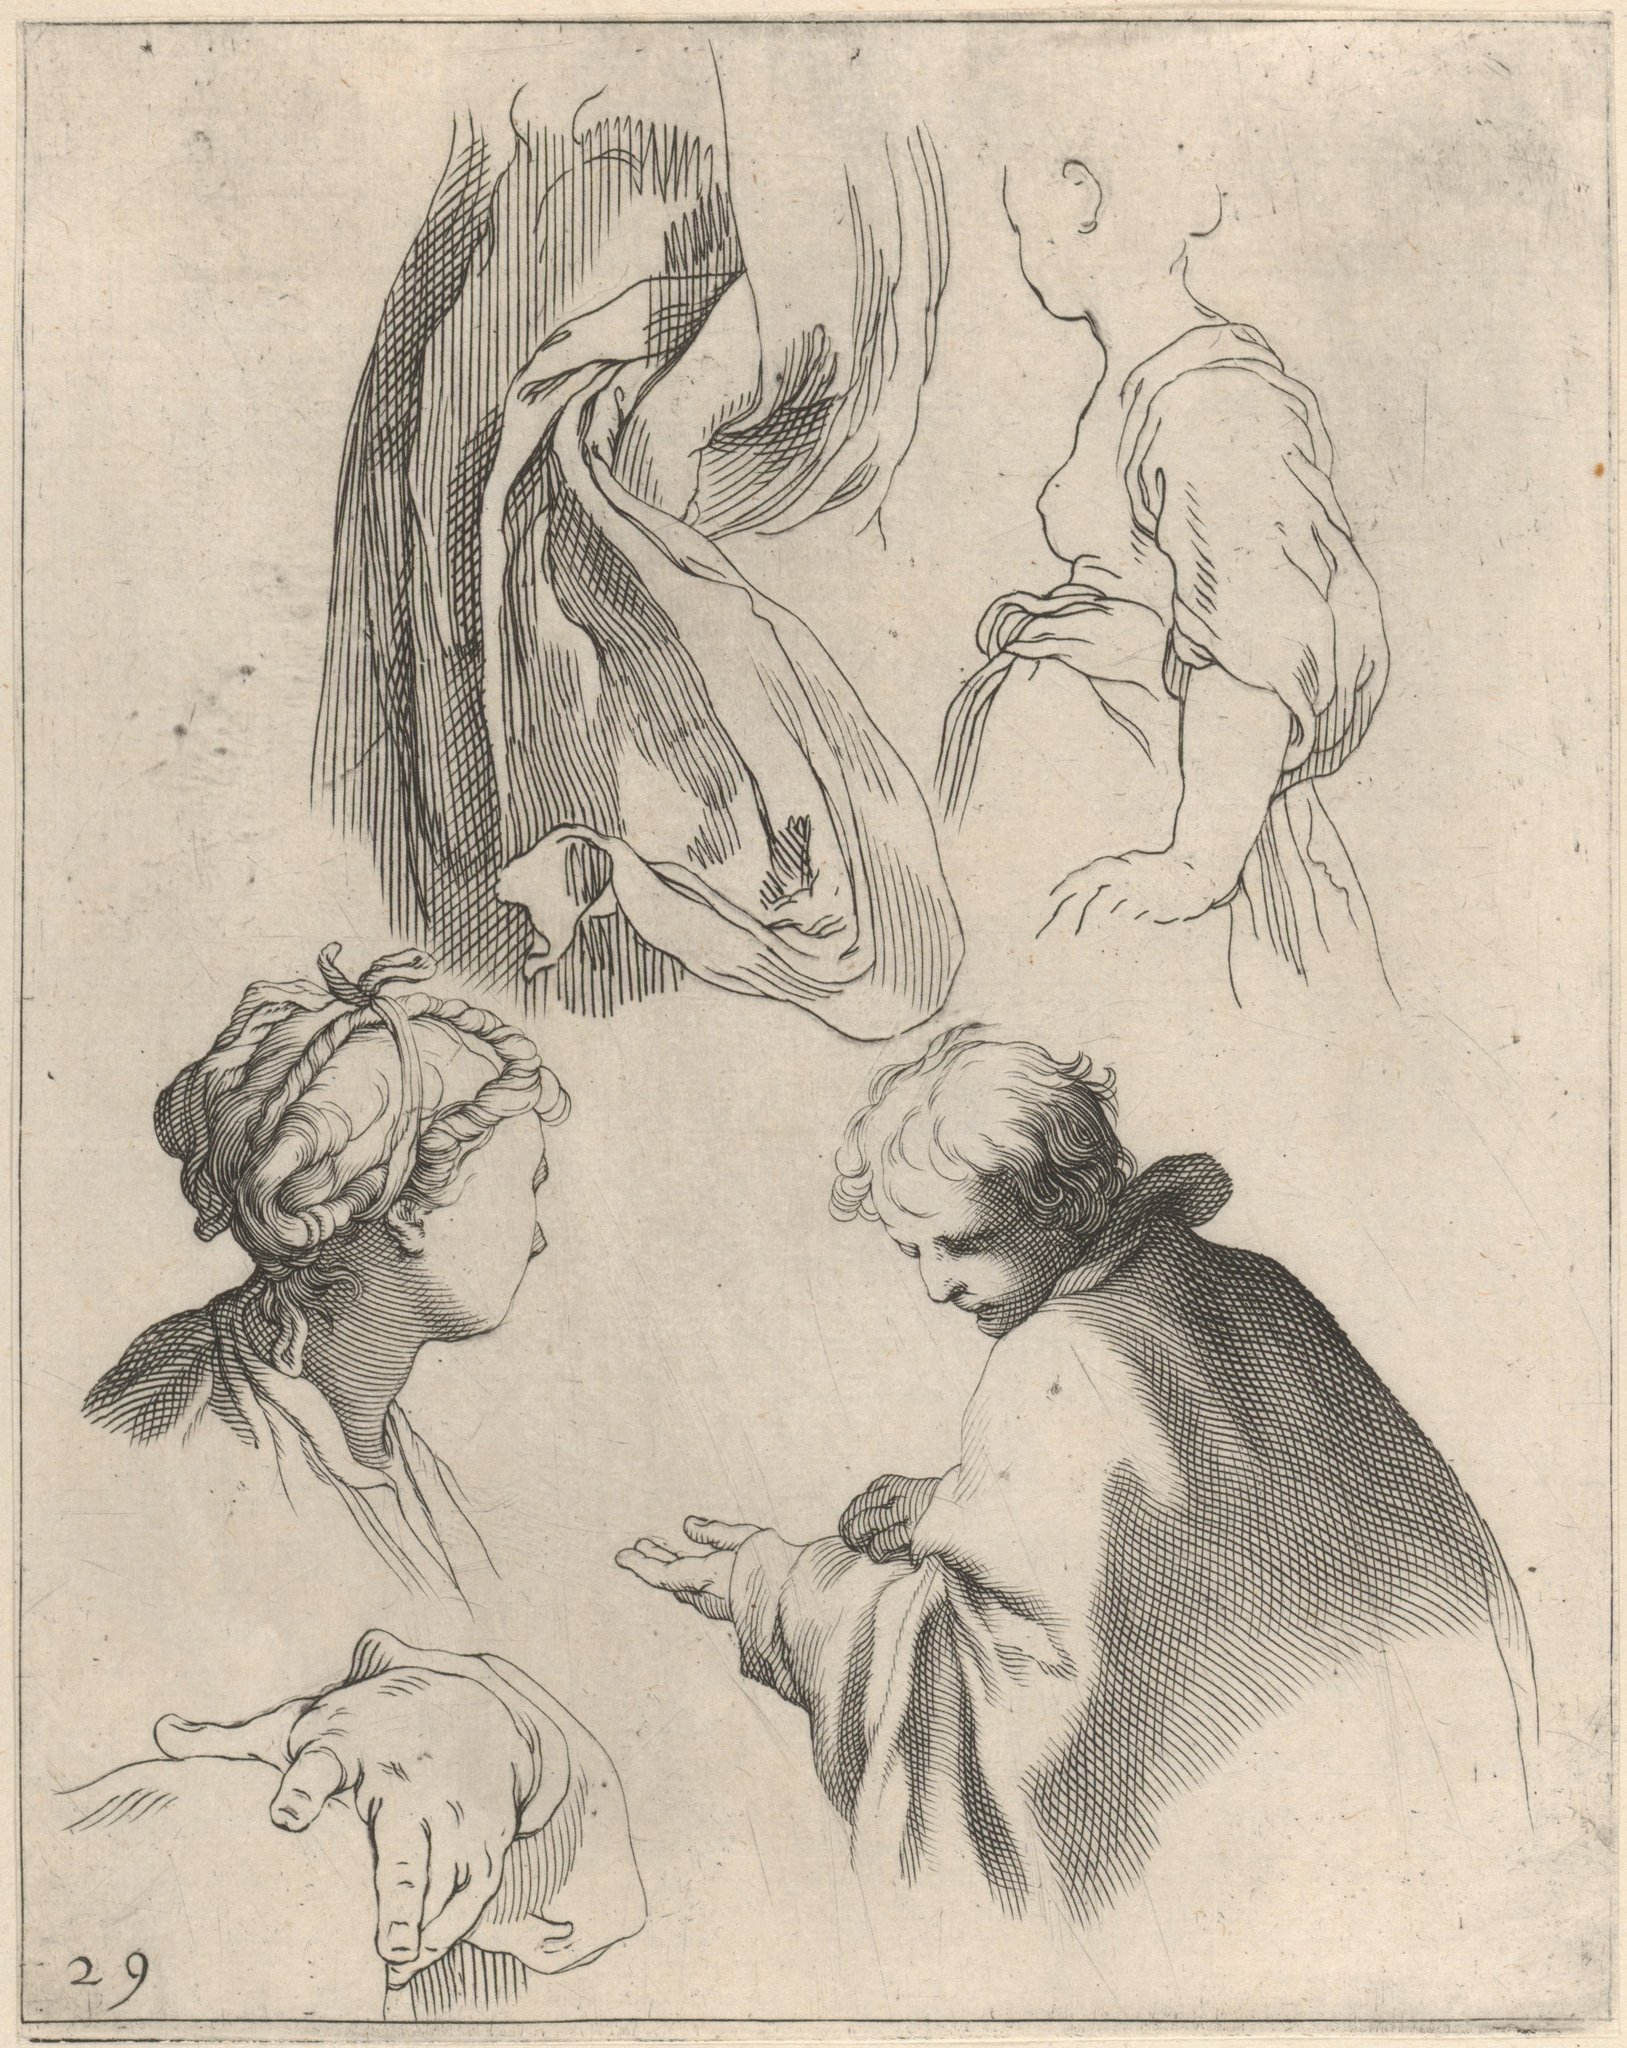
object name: print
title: Figure Studies, from "Drawing Book"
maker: frederick bloemaert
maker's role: artist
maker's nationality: dutch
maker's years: 1610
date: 1650-1656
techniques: engraving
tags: boys,men,women